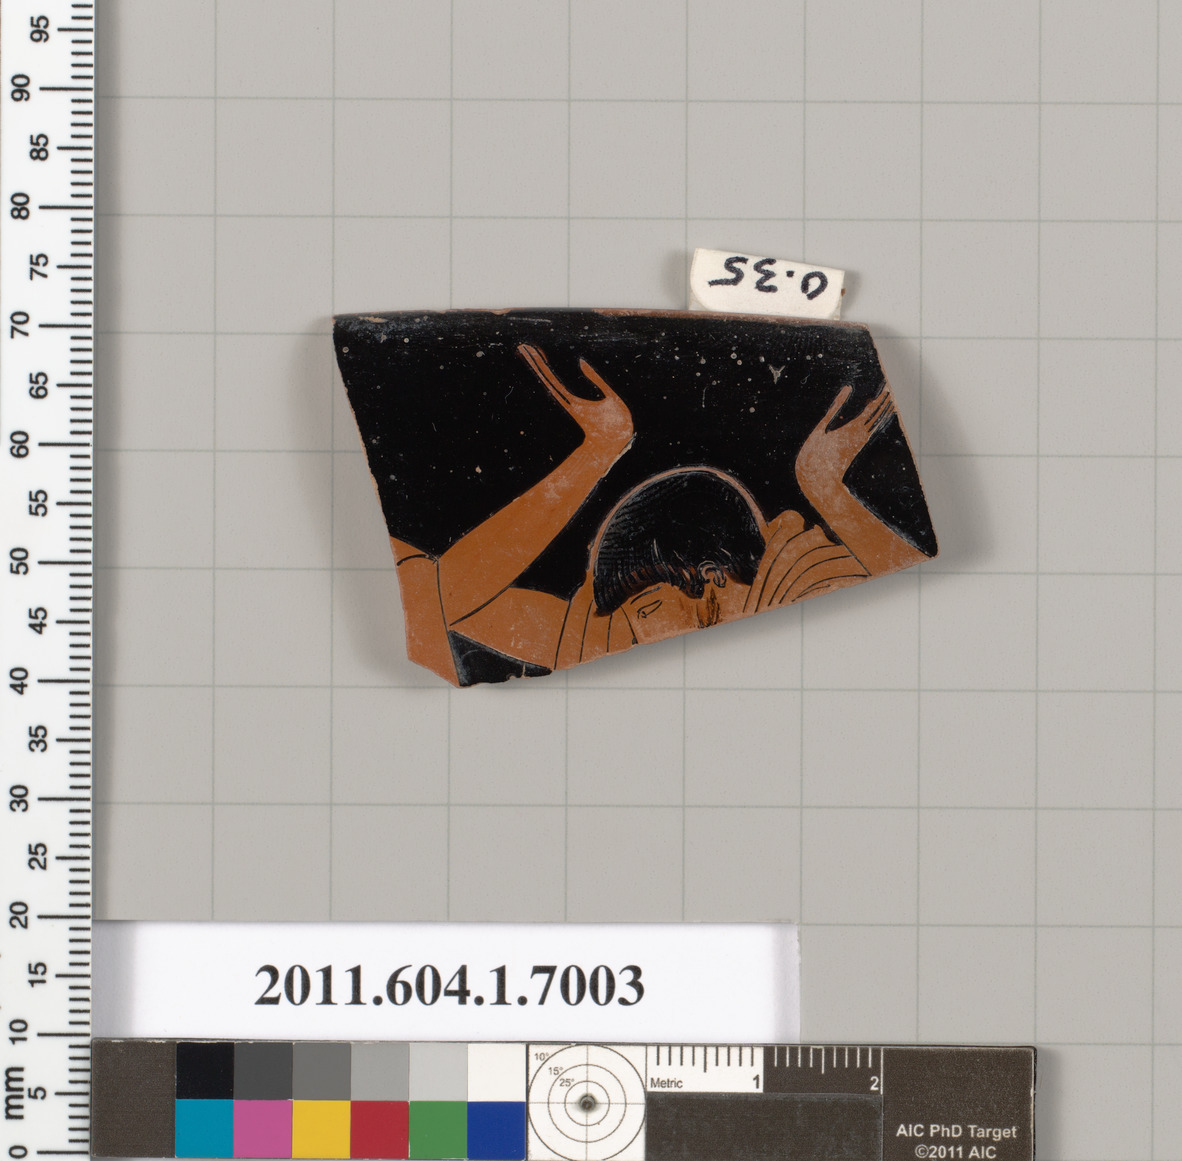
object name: kylix fragment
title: Terracotta rim fragment of a kylix (drinking cup)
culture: greek, attic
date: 500-480 BCE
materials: terracotta